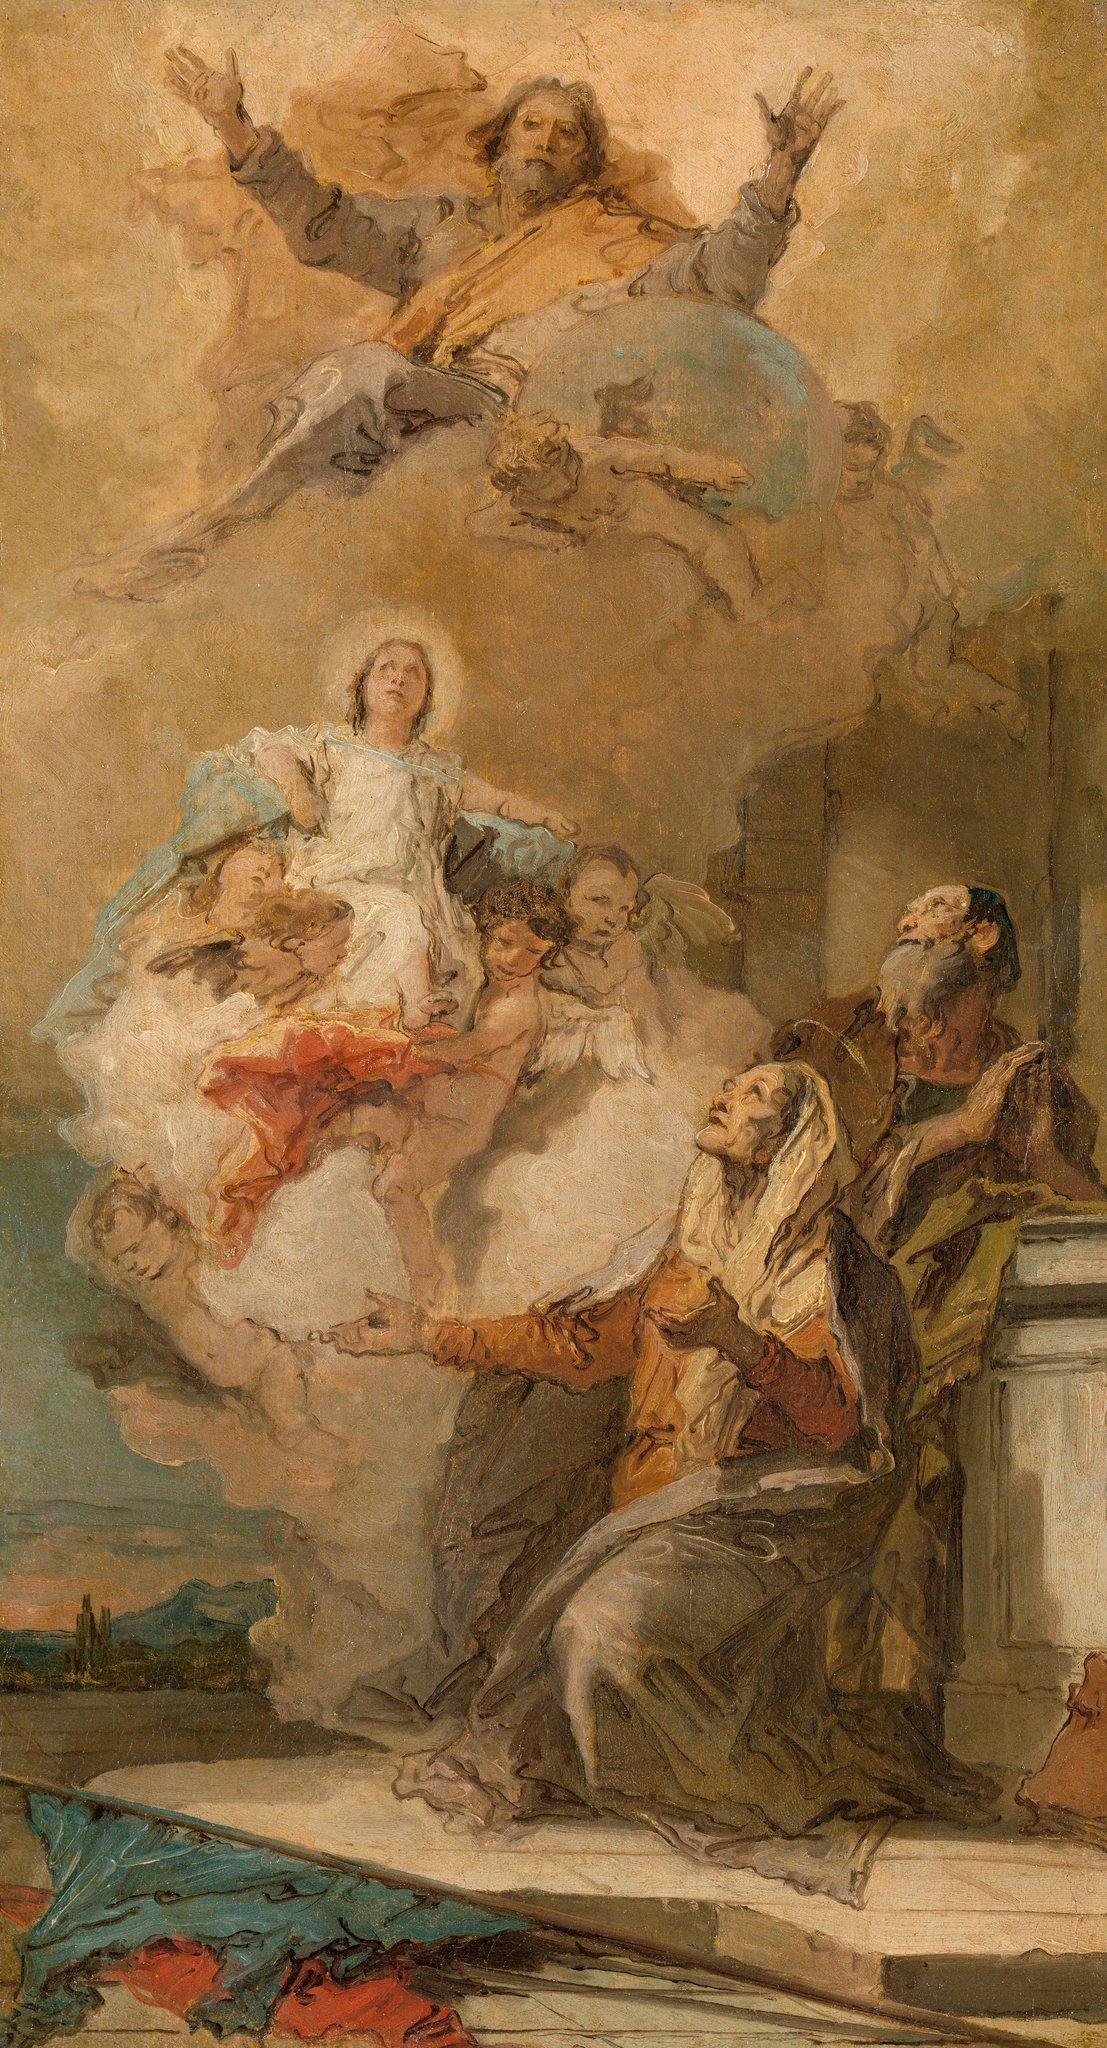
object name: sketch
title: The Immaculate Conception (Joachim en Anna receiving the Virgin Mary from God the Father)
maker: giovanni battista tiepolo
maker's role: draughtsman, painter, print maker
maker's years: 1696-1770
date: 1757-1759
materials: canvas, oil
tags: (immaculate) conception of mary represented symbolically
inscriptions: inscription: ‘Modello originale d[i Ti]epolo per la tavola dell'altare nel Convento di S. Chiara in Cividale. Comprato della galeria Barlese Tiepolo per lire sessantatre li 23 maggio 1808.’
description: This is a study for a large altarpiece. It is an unusual variant on the theme of the Immaculate Conception (the doctrine that the Virgin Mary was conceived without original sin), in which Mary is shown being sent by god directly from heaven to her parents. Tiepolo was among the earliest painters to execute oil-sketches as independent works in which the richness and brilliance of his brushwork and colouring could be fully enjoyed.